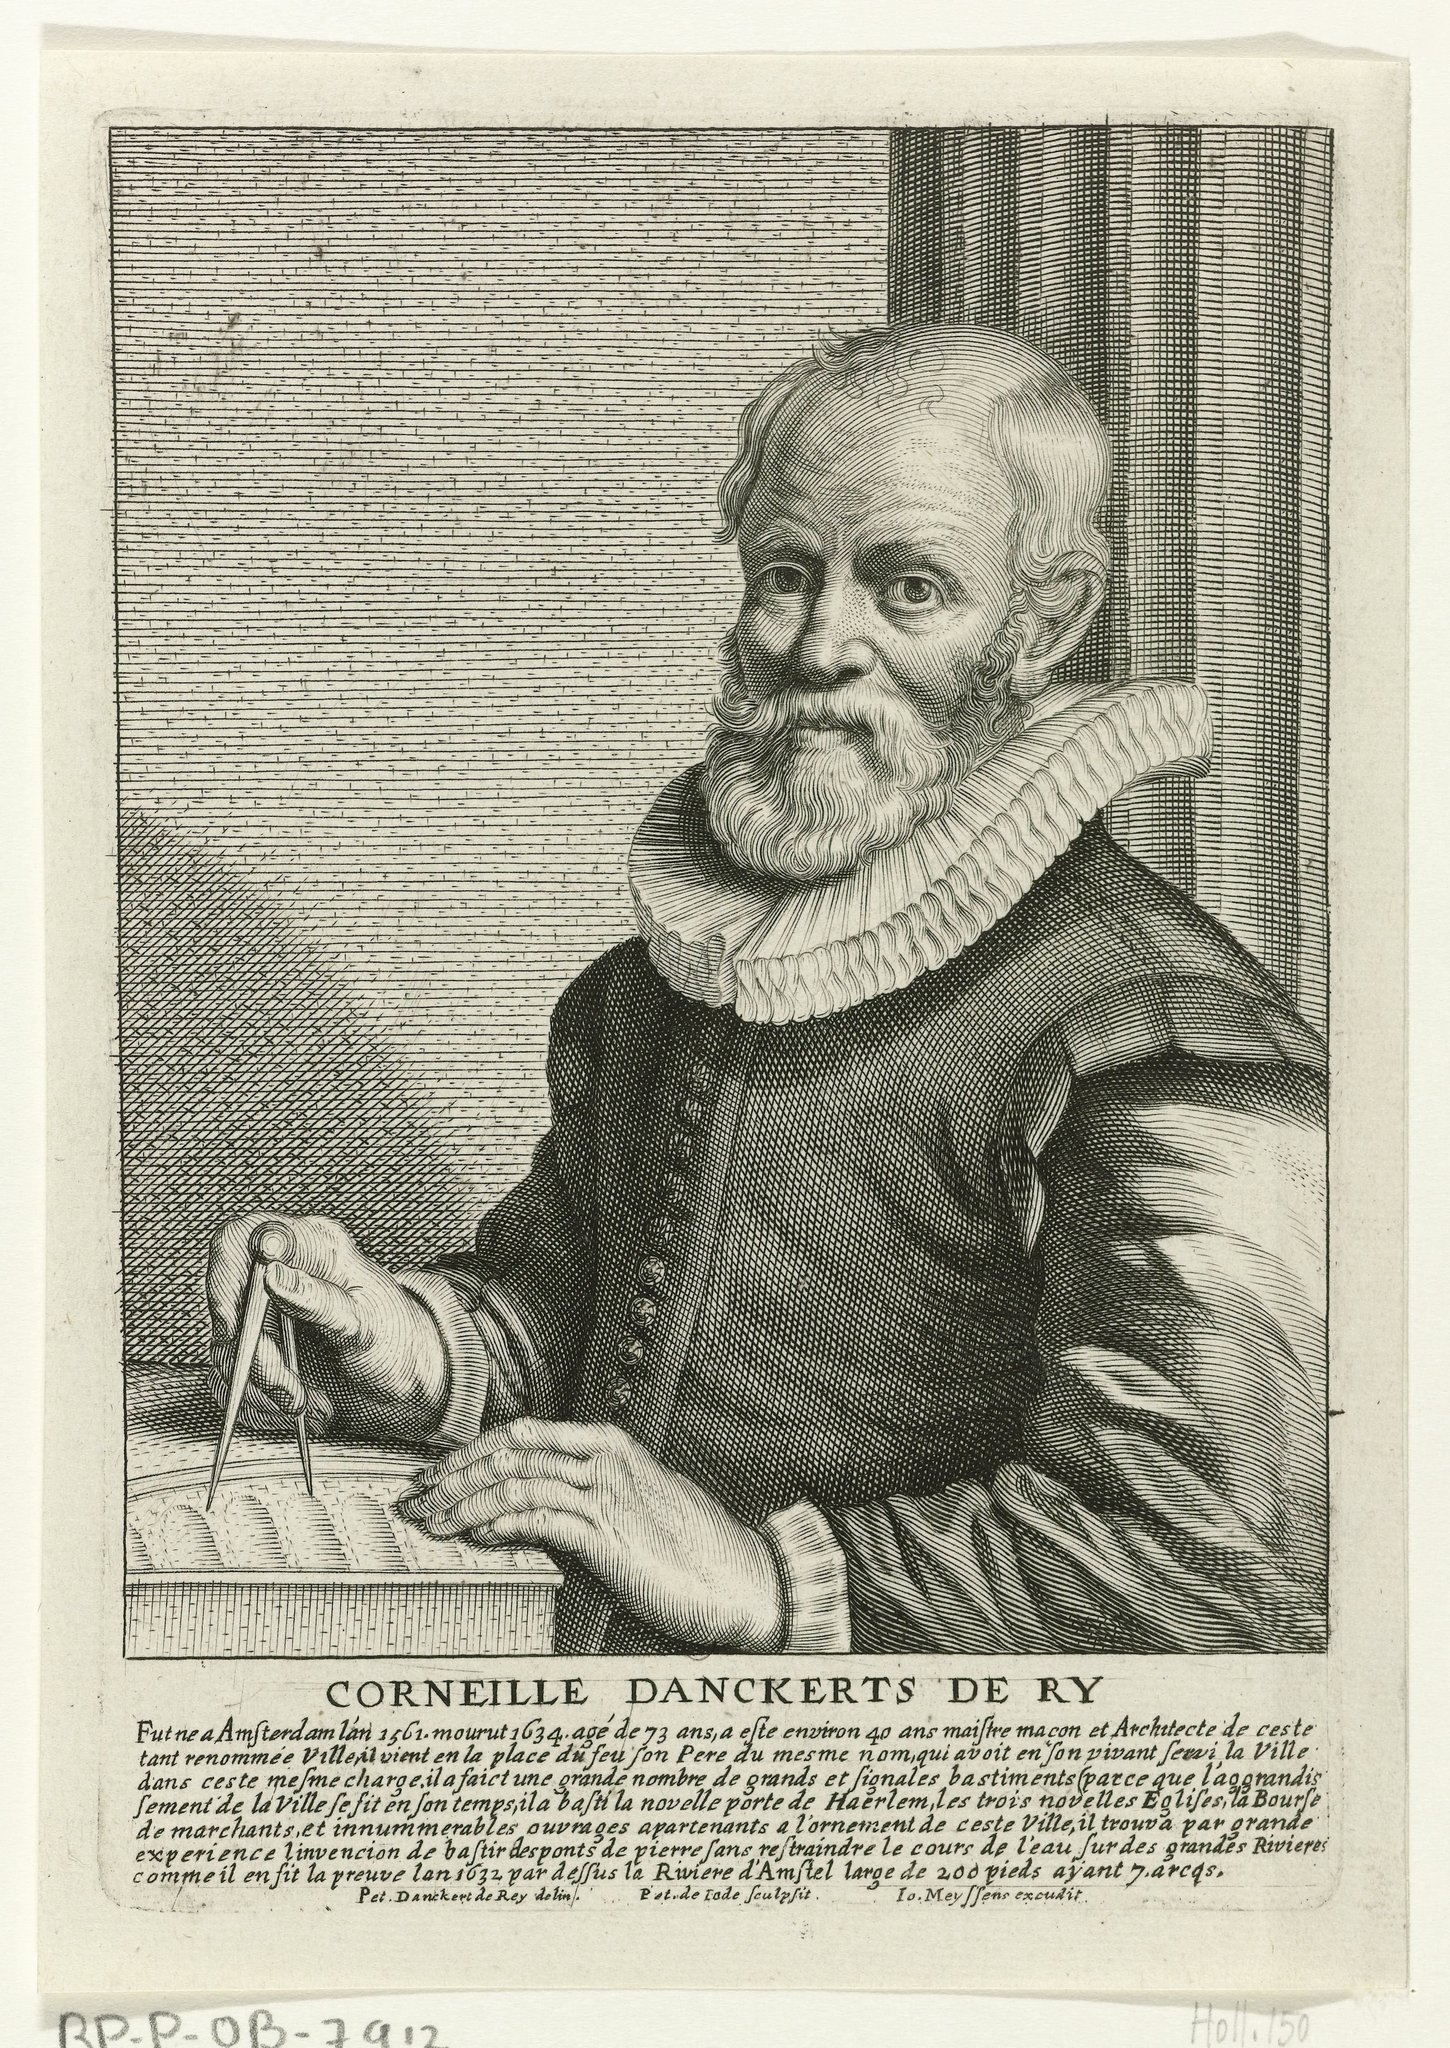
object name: print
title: Portret van Cornelis Danckerts de Rij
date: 1628-1670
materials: paper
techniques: engraving, etching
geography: antwerp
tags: compasses, portrait, self-portrait of architect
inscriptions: collector's mark: Lugt 2228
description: Portret van architect Cornelis Danckerts de Rij op 73-jarige leeftijd, ten halven lijve. In zijn rechterhand houdt hij een passer. In de marge de naam van de geportretteerde en een zevenregelig onderschrift in het Frans.